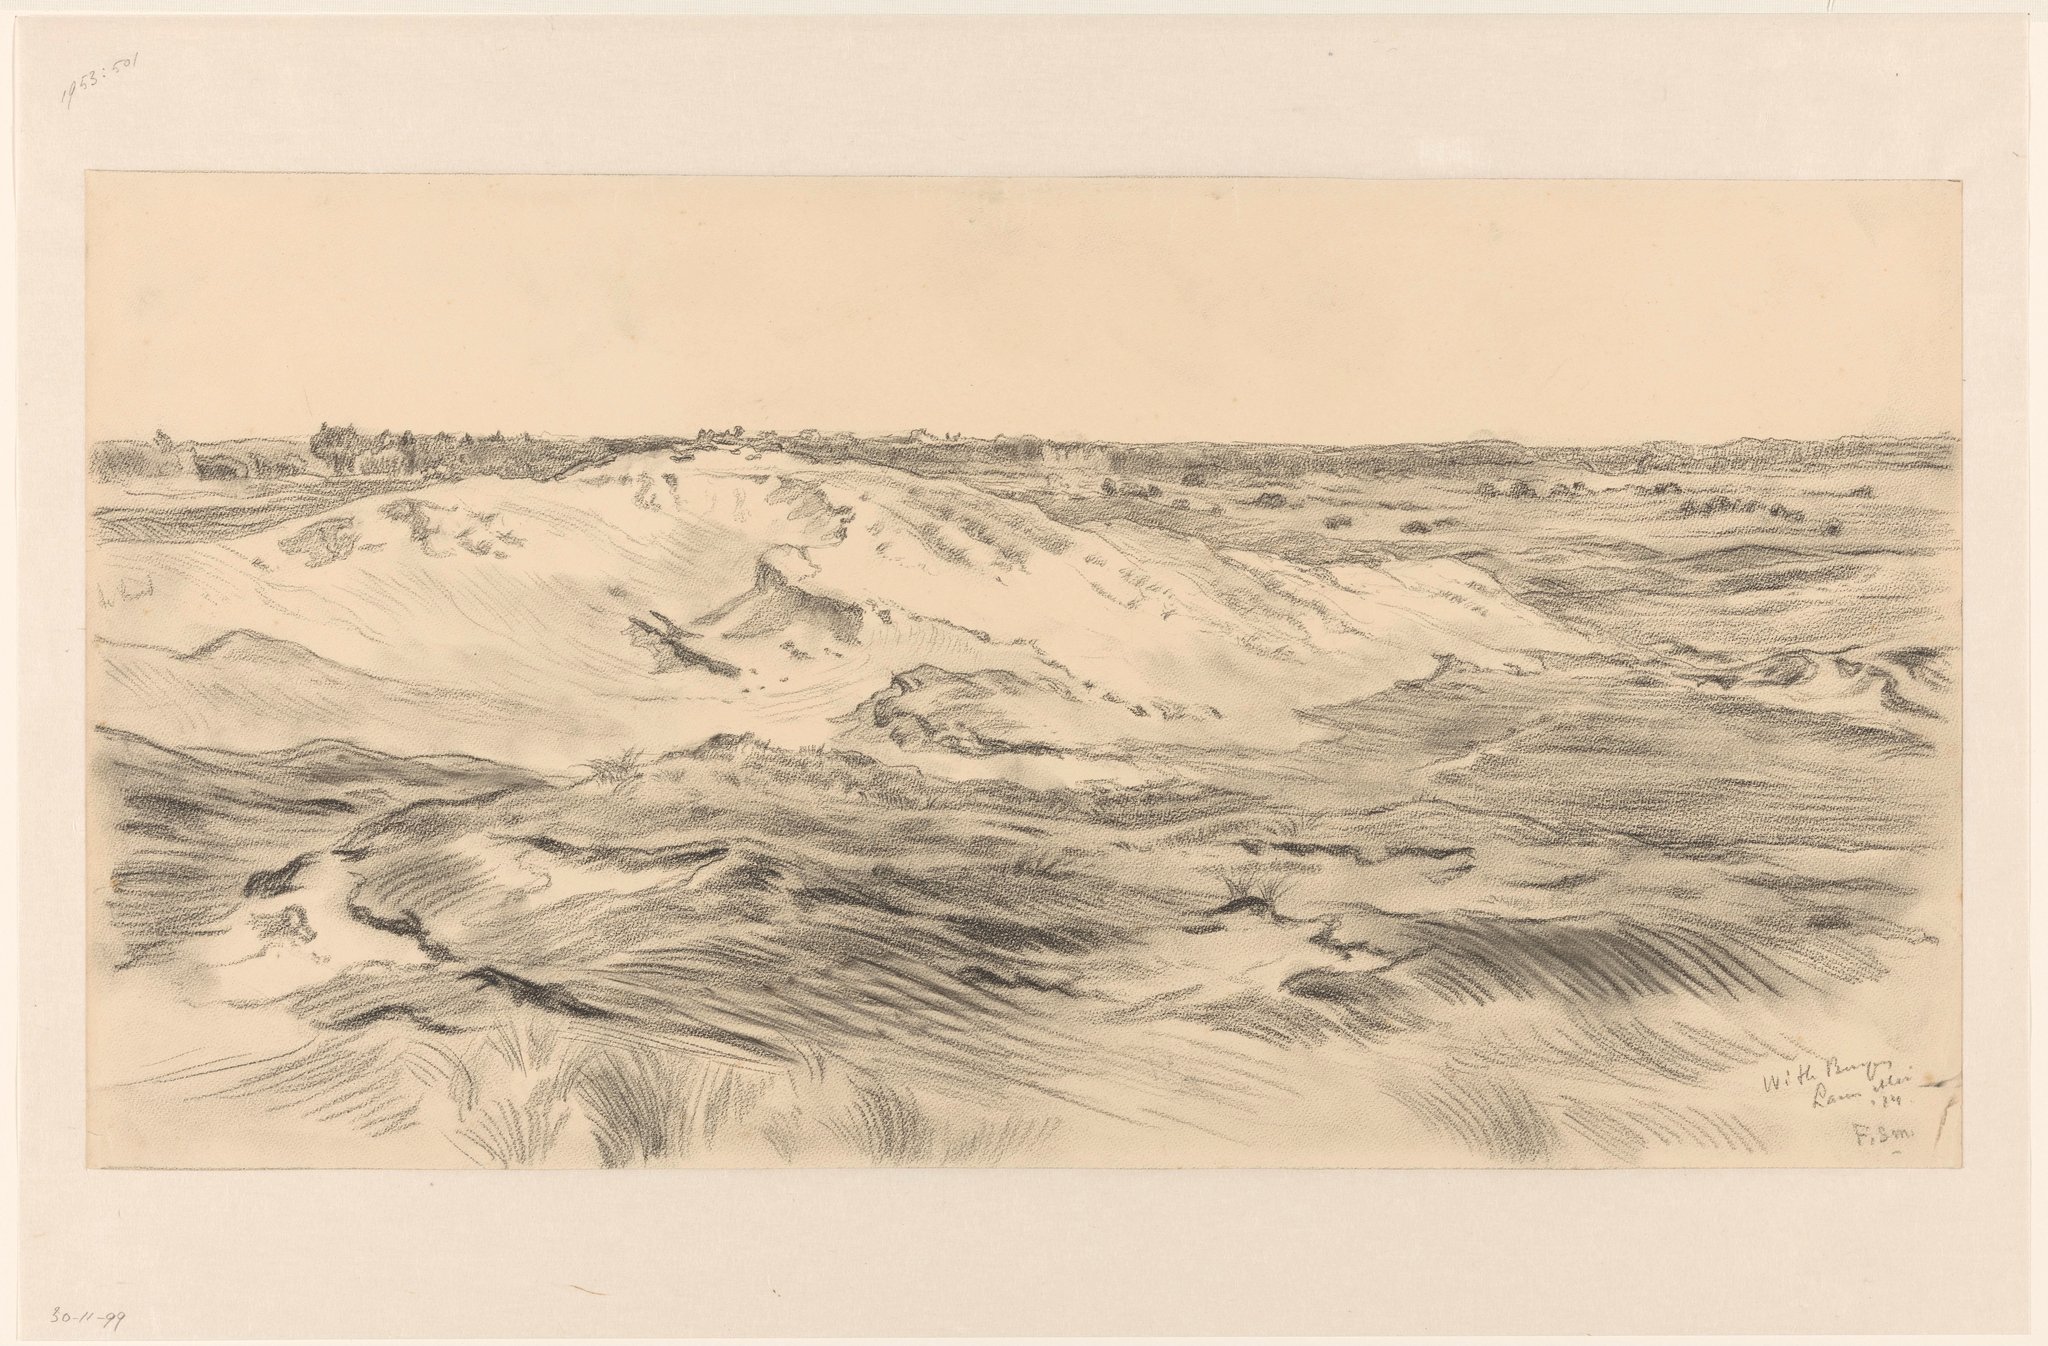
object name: drawing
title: De Witte Bergen te Laren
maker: frans smissaert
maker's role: draughtsman, print maker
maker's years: 1862-1944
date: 1905-1914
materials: charcoal, paper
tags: city-view in general; 'veduta'